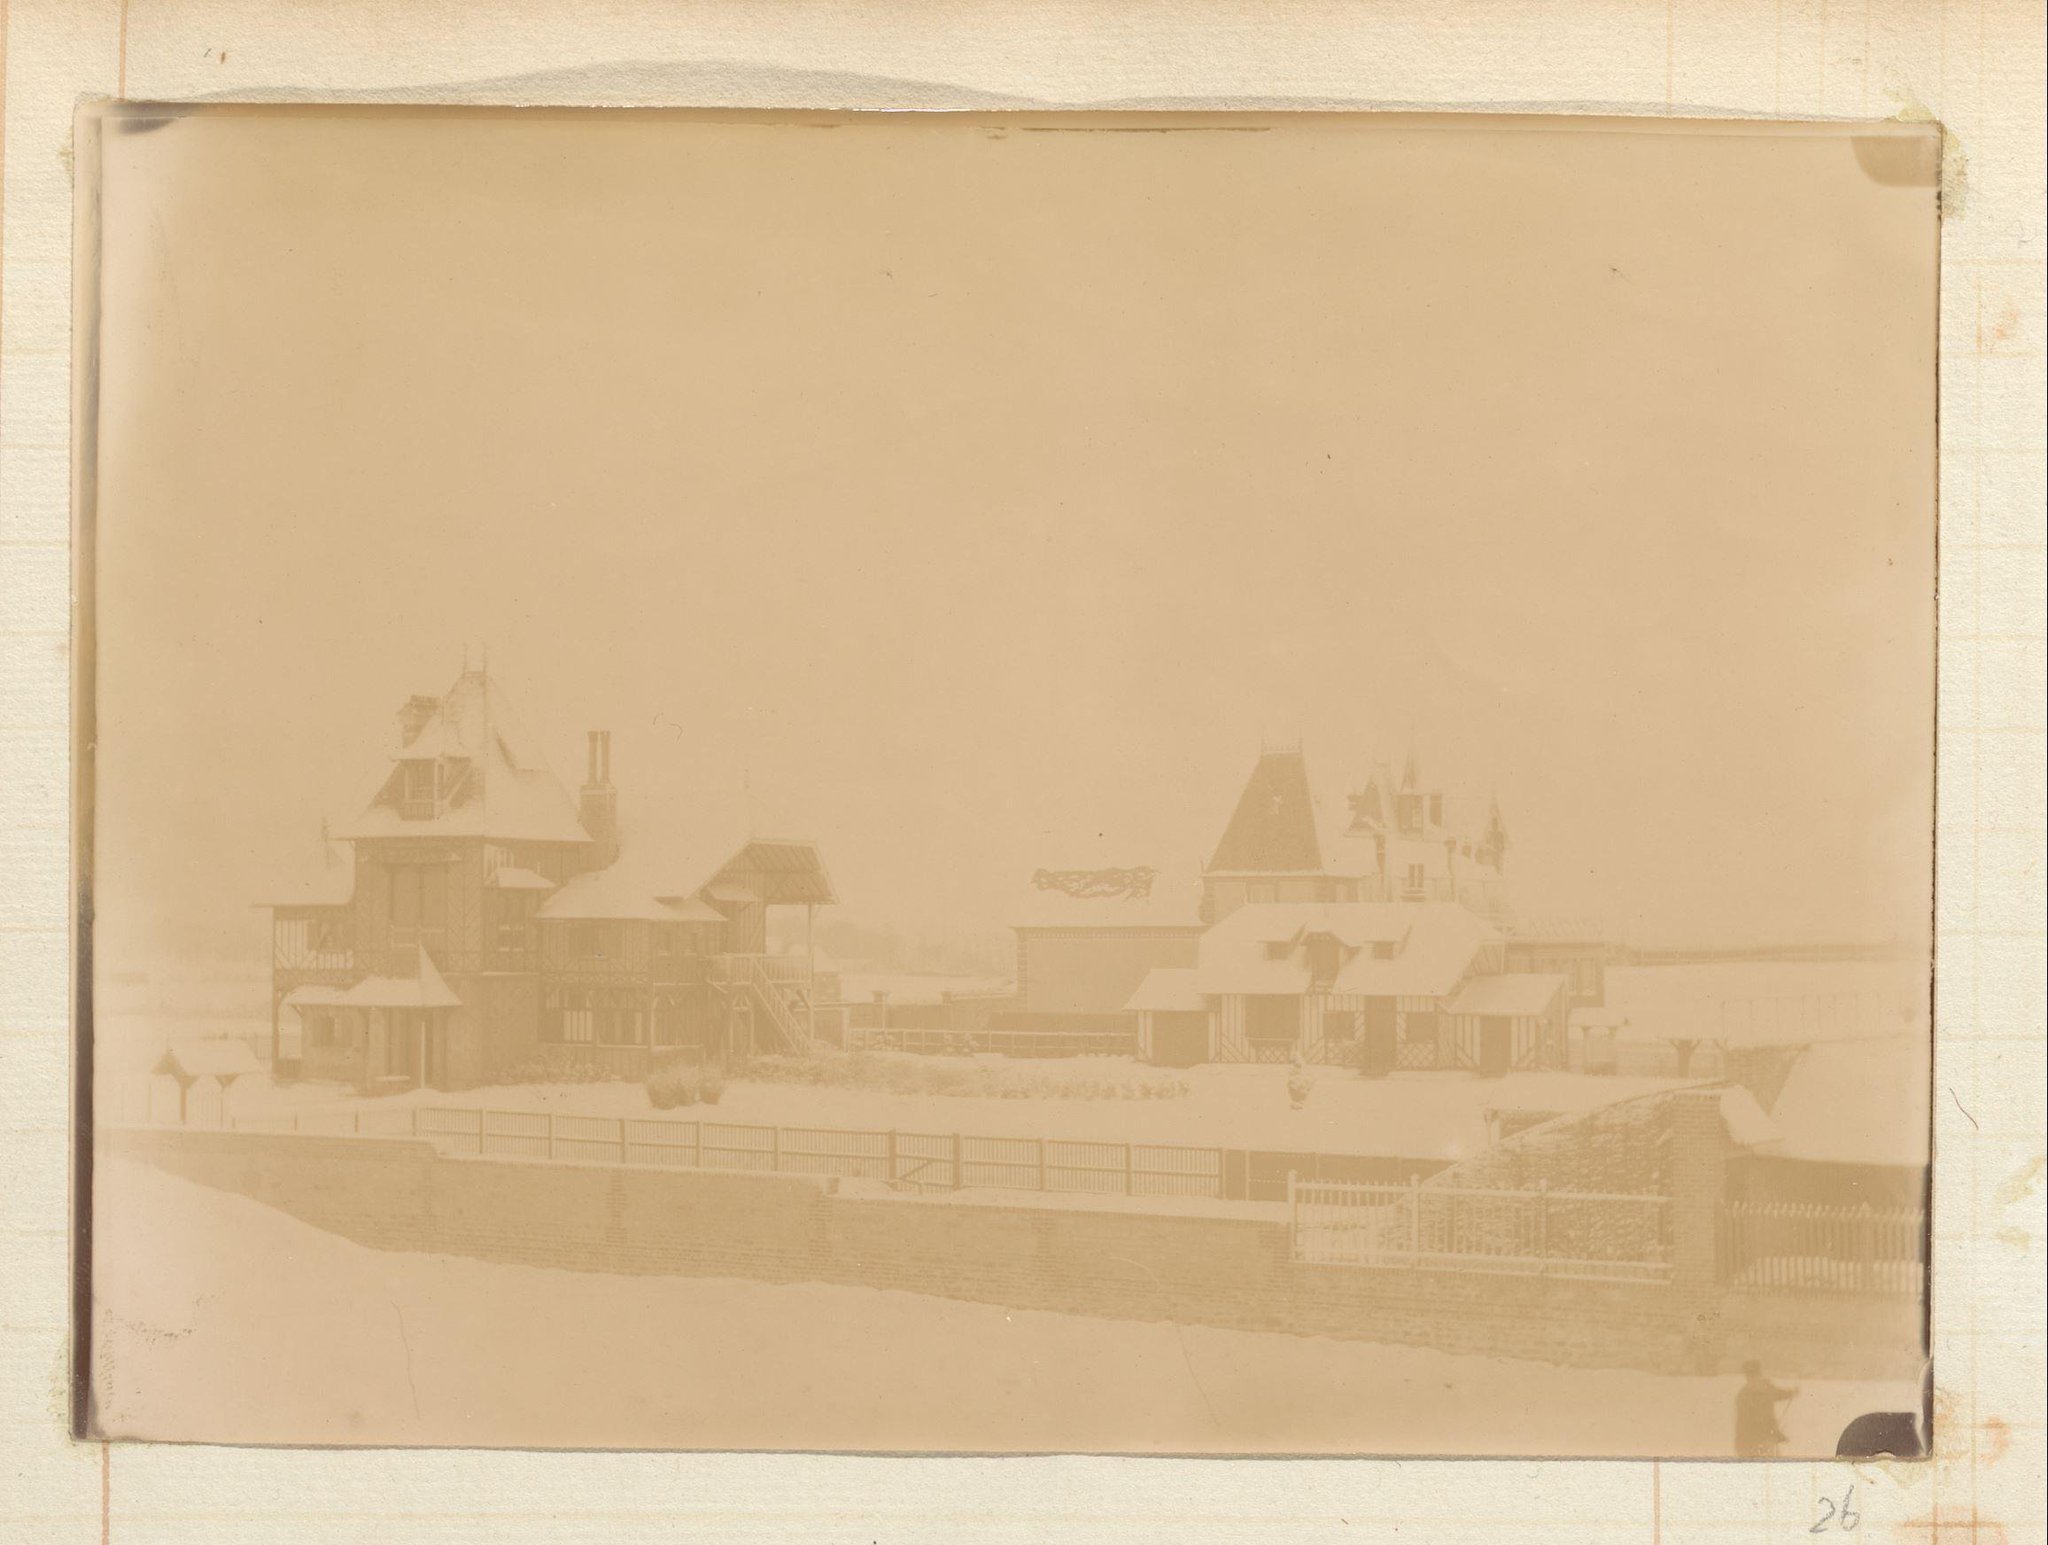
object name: photograph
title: Ommuurd complex van vakwerkhuizen in de sneeuw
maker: Anonymous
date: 1880-1900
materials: paper, photographic support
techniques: gelatin silver print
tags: villa, snow